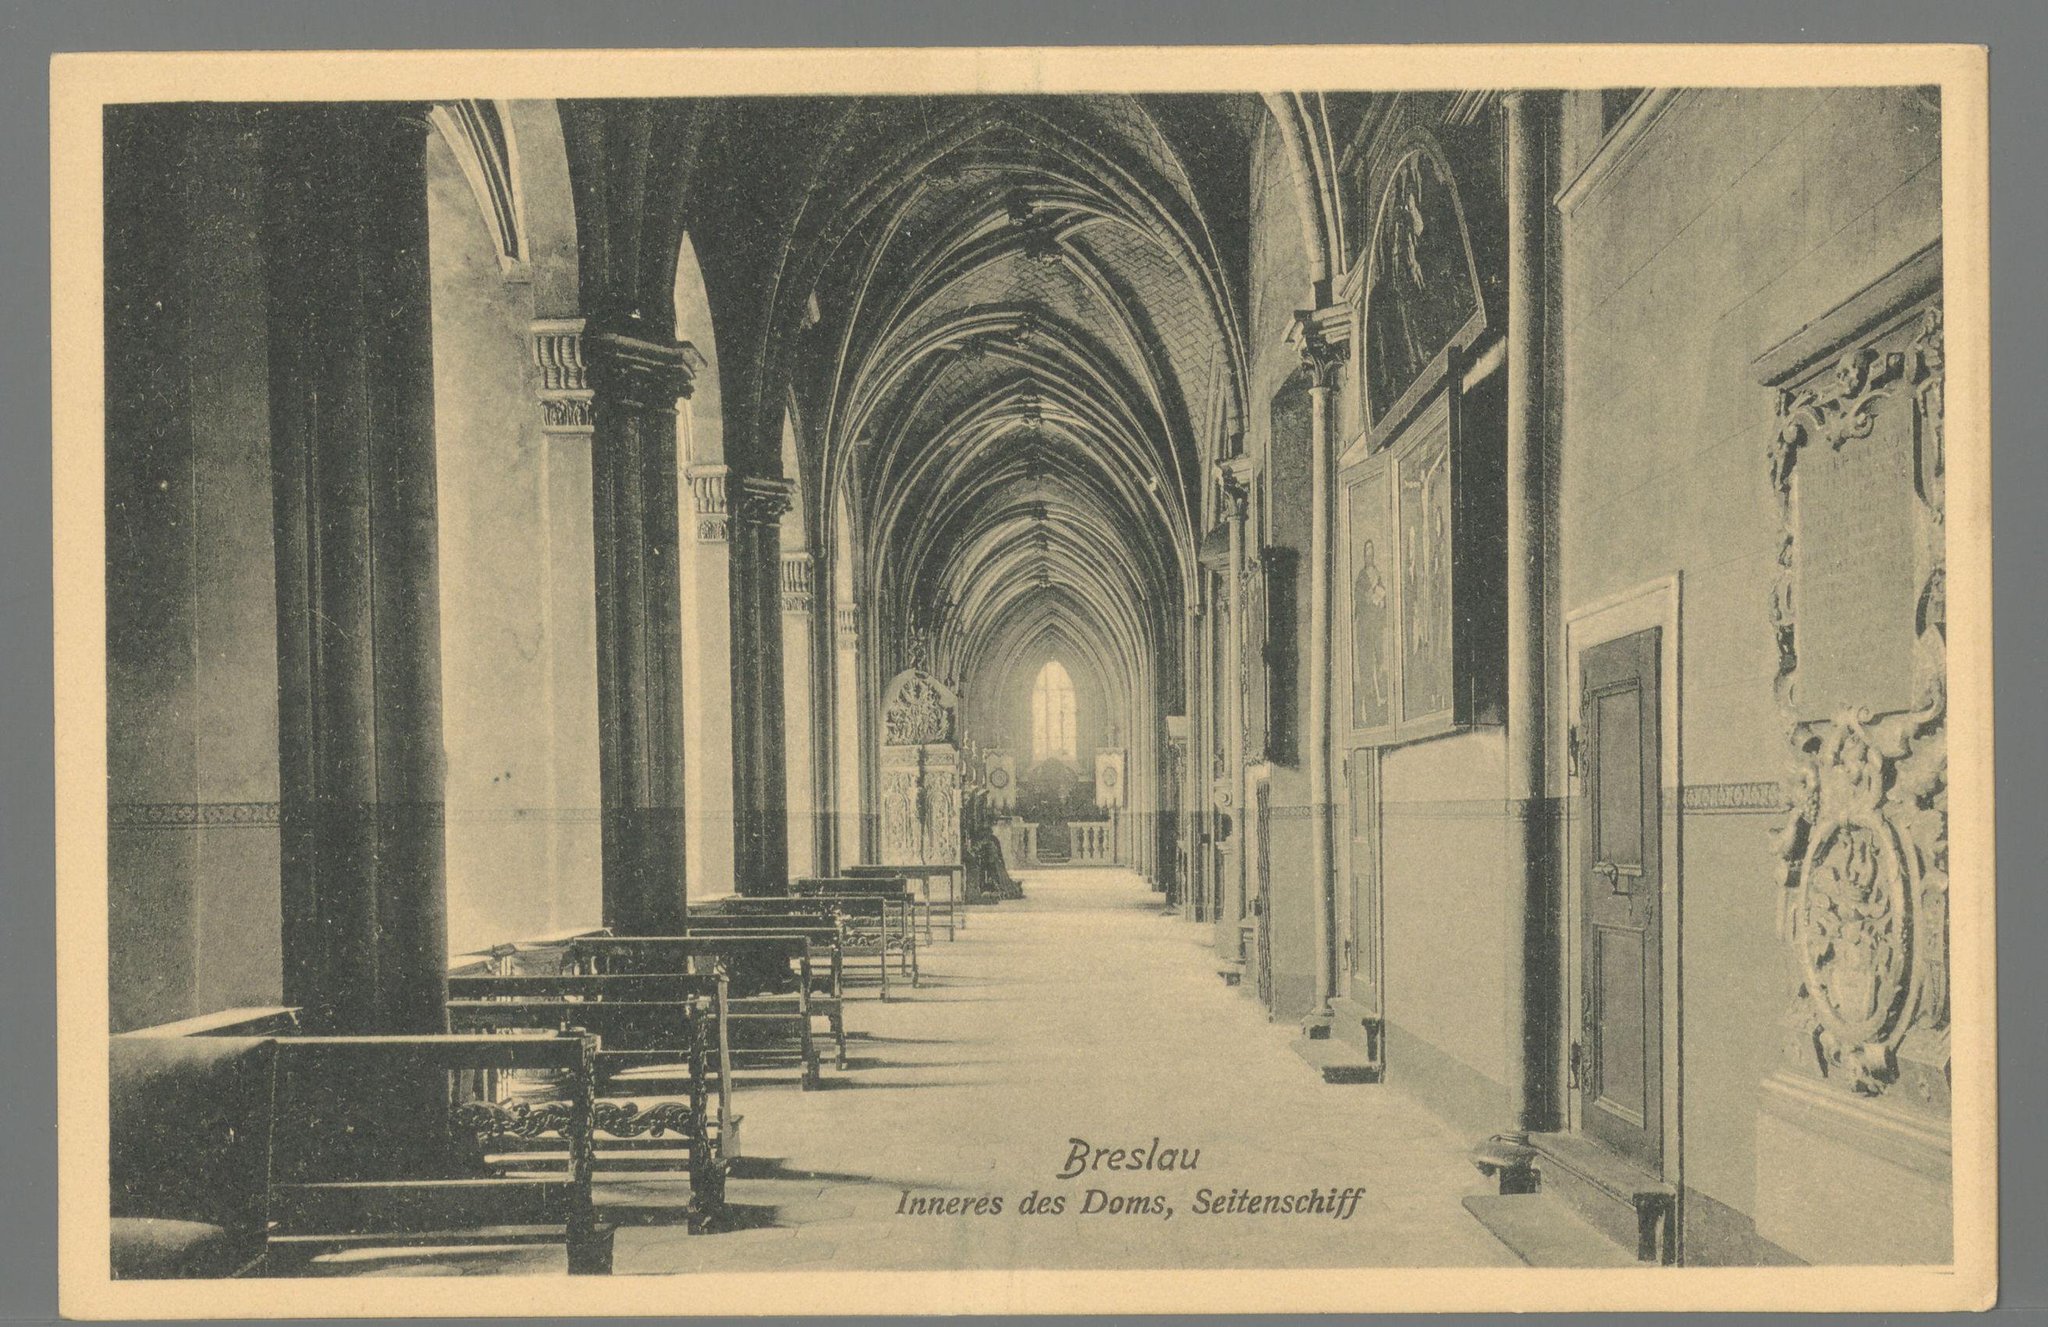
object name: ansichtkaart, prentbriefkaart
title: Breslau. Inneres des Doms, Seitenschiff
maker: Anonymous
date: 1908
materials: cardboard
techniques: photograph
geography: leipzig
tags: interior of church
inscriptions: date